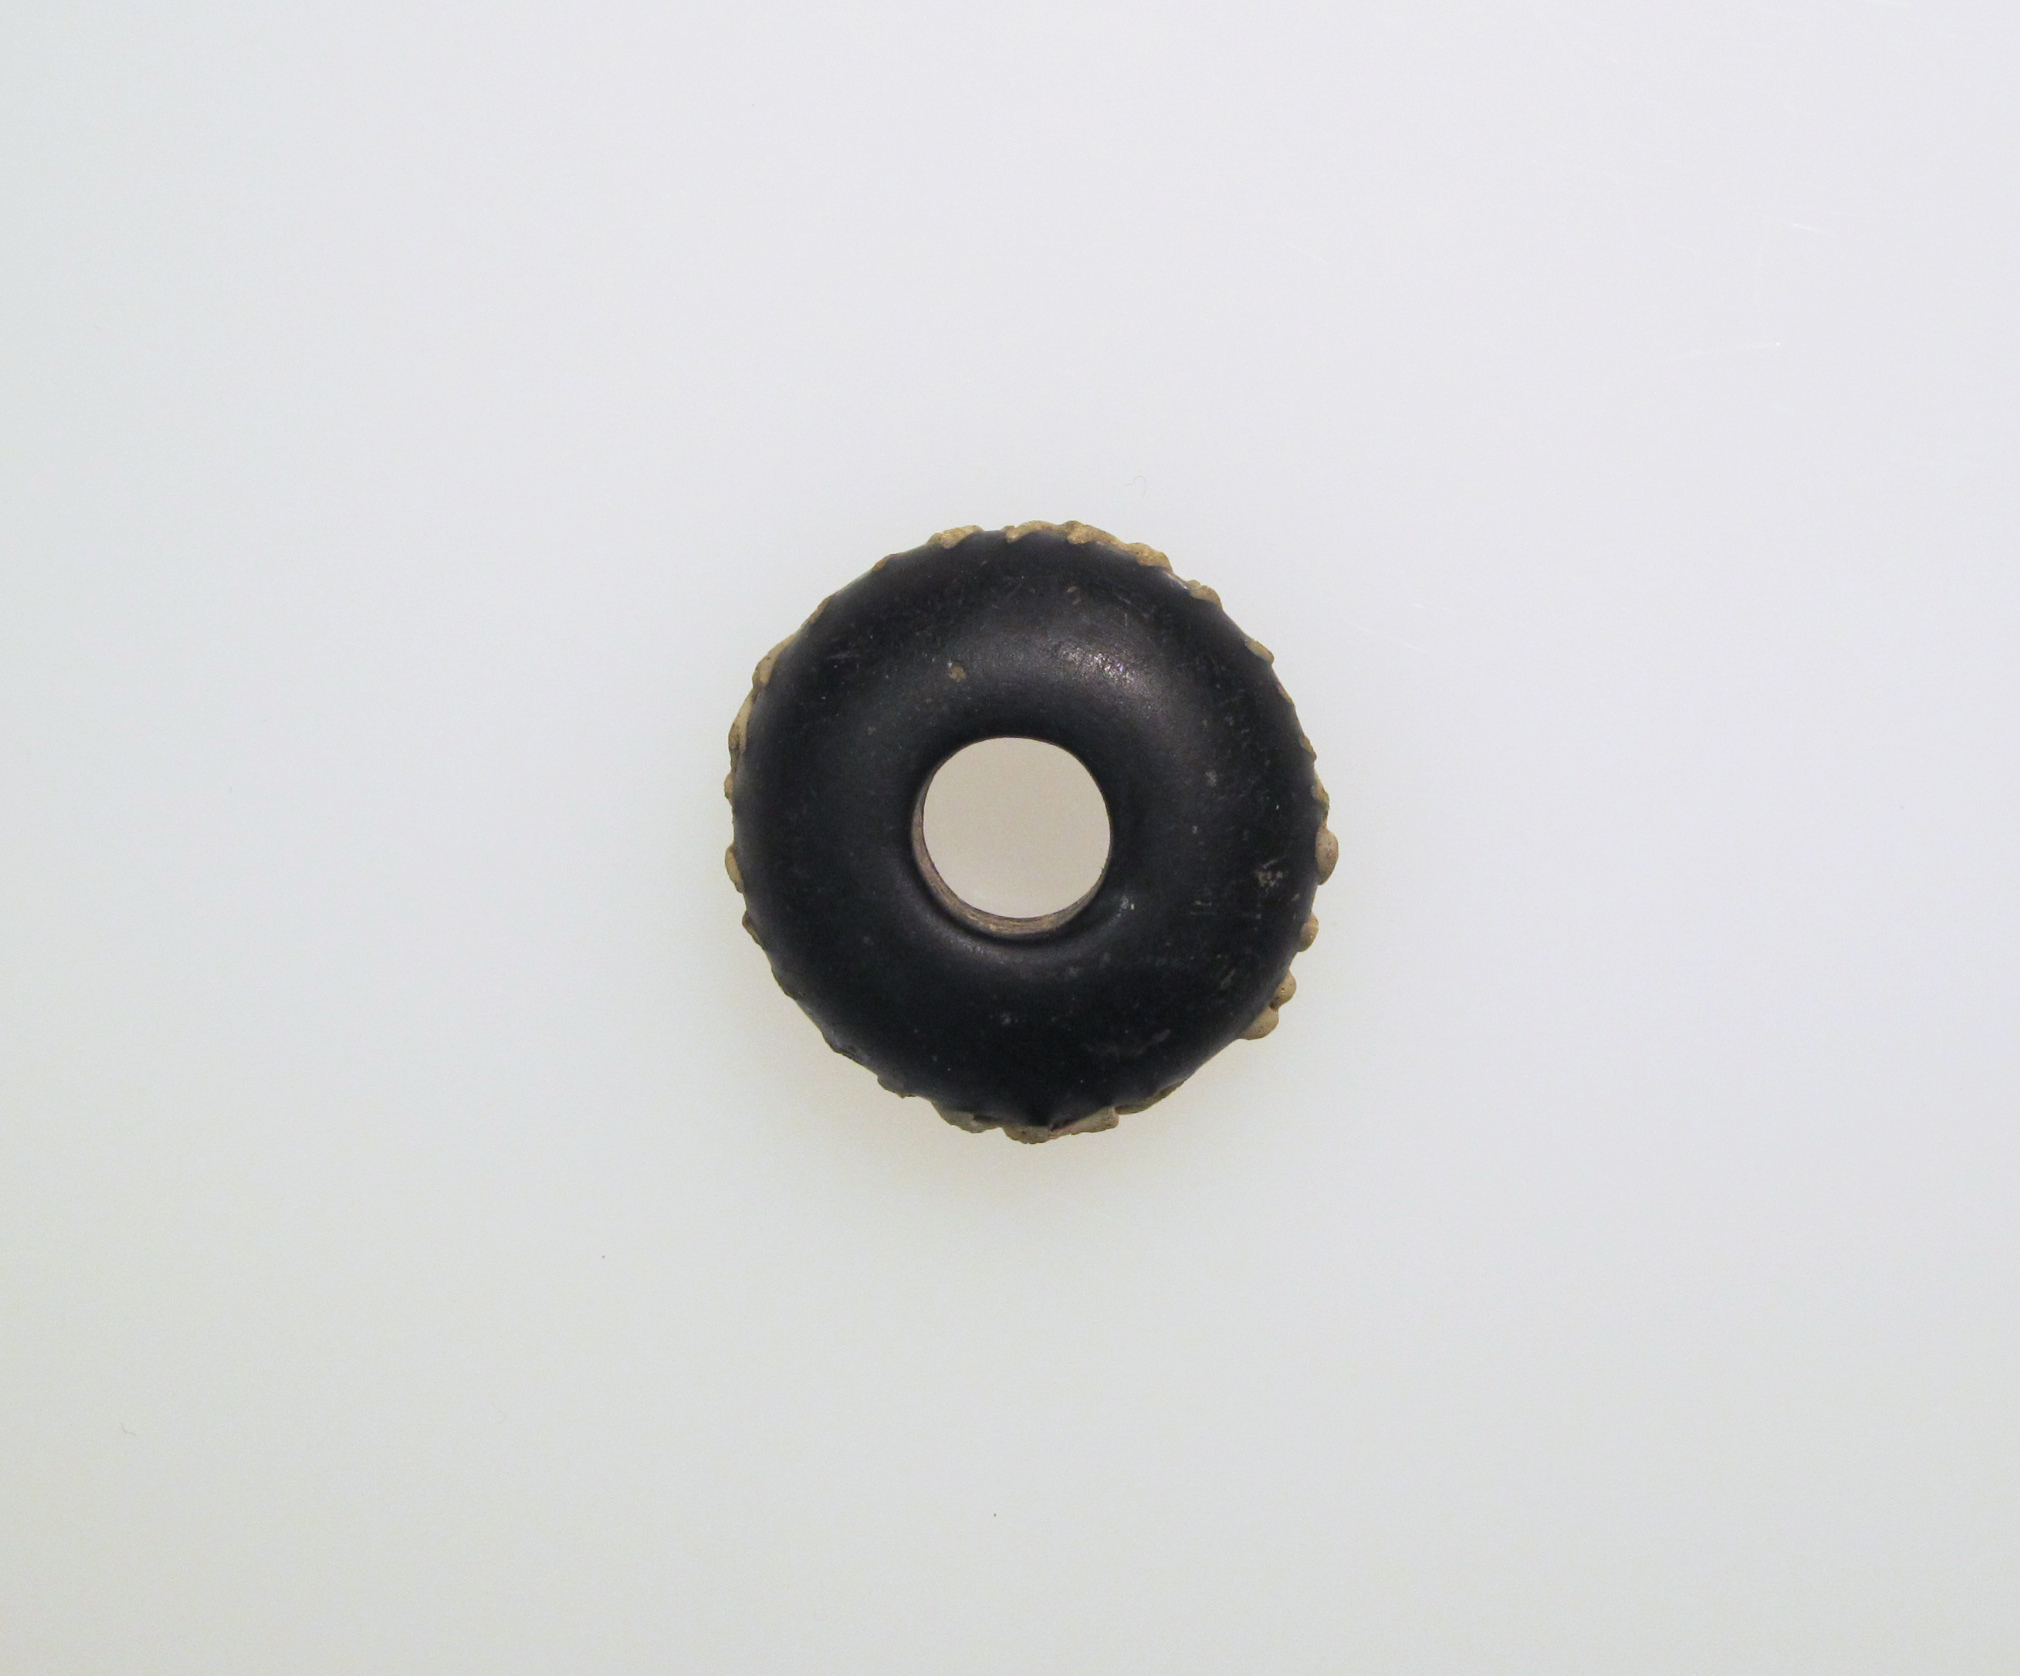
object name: bead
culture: roman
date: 670 BCE-330 CE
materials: glass